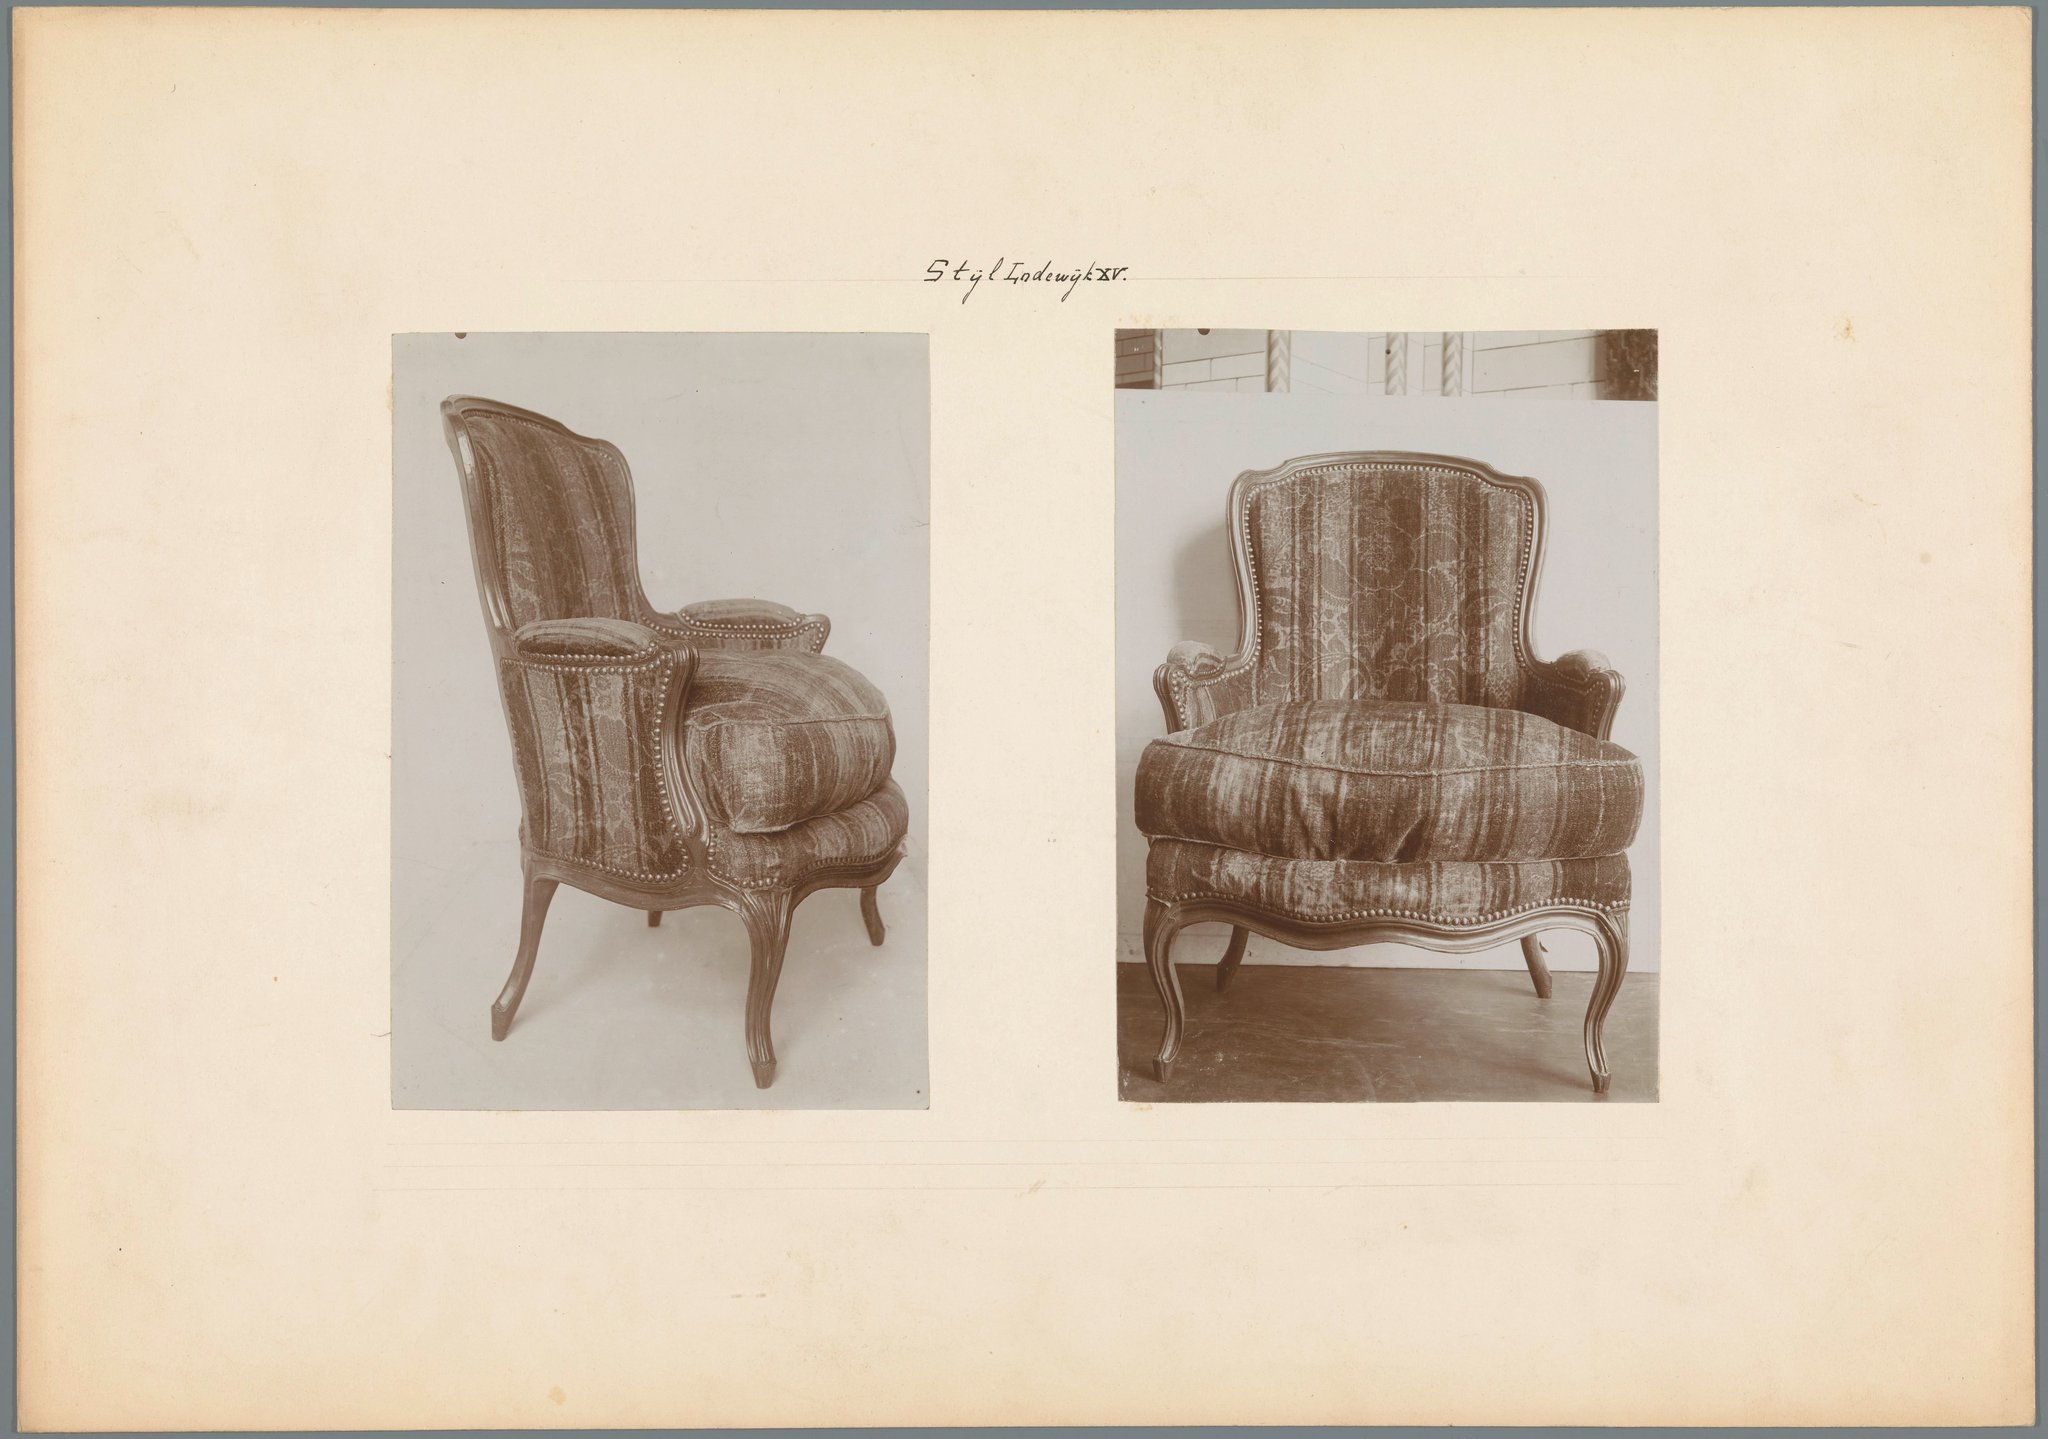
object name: photograph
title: Voor- en zijaanzicht van een armstoel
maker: Anonymous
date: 1875-1900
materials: cardboard, photographic support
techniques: collodion silver print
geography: europe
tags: armchair, seat, europe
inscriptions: inscription: ‘Stijl Lodewijk XV.’, collector's mark: ‘INSTITUUT VOOR KUNST-NIJVERHEIDSONDERWIJS GABRIËL METSUSTRAAT No. 16 AMSTERDAM’, collector's mark: ‘KUNSTNIJVERHEIDSCHOOL QUELLINUS AMSTERDAM FRANS HALSSTRAAT 14.’